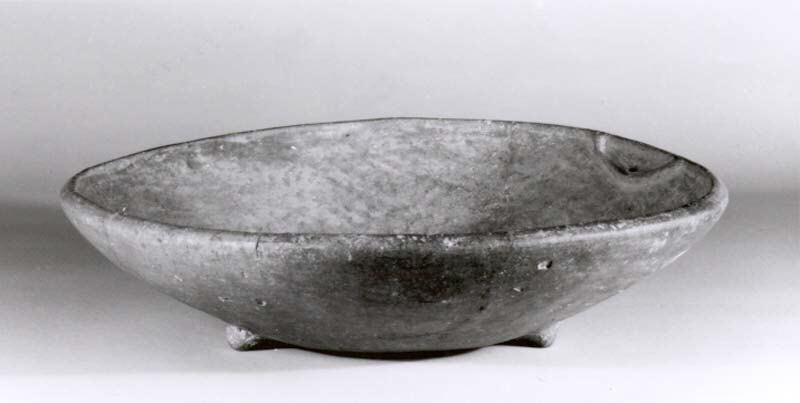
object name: bowl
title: "Worm" bowl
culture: iranian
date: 1400-1101 BCE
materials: ceramic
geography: iran